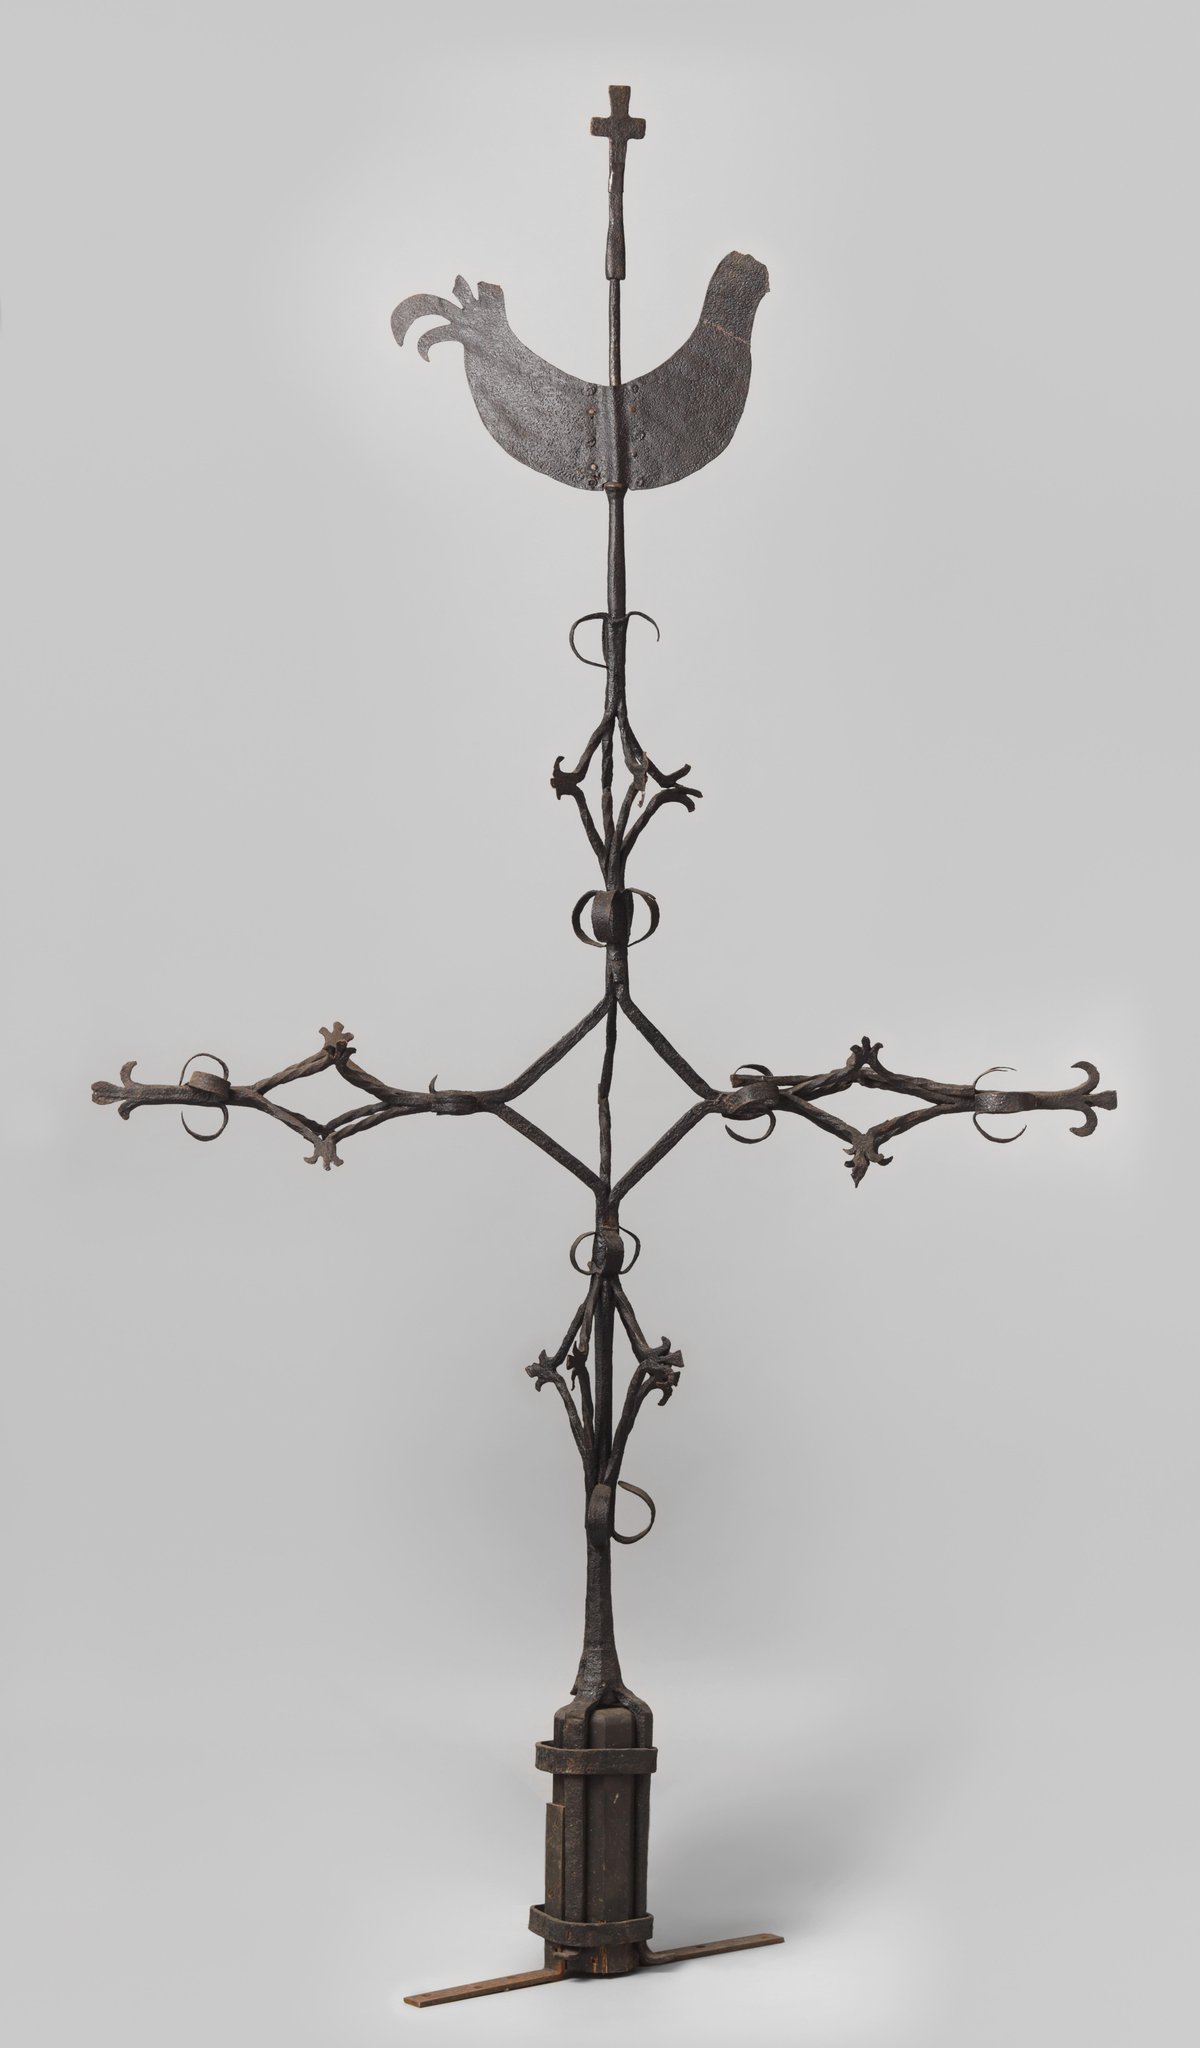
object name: cross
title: Torenkruis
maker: Anonymous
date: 1505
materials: iron